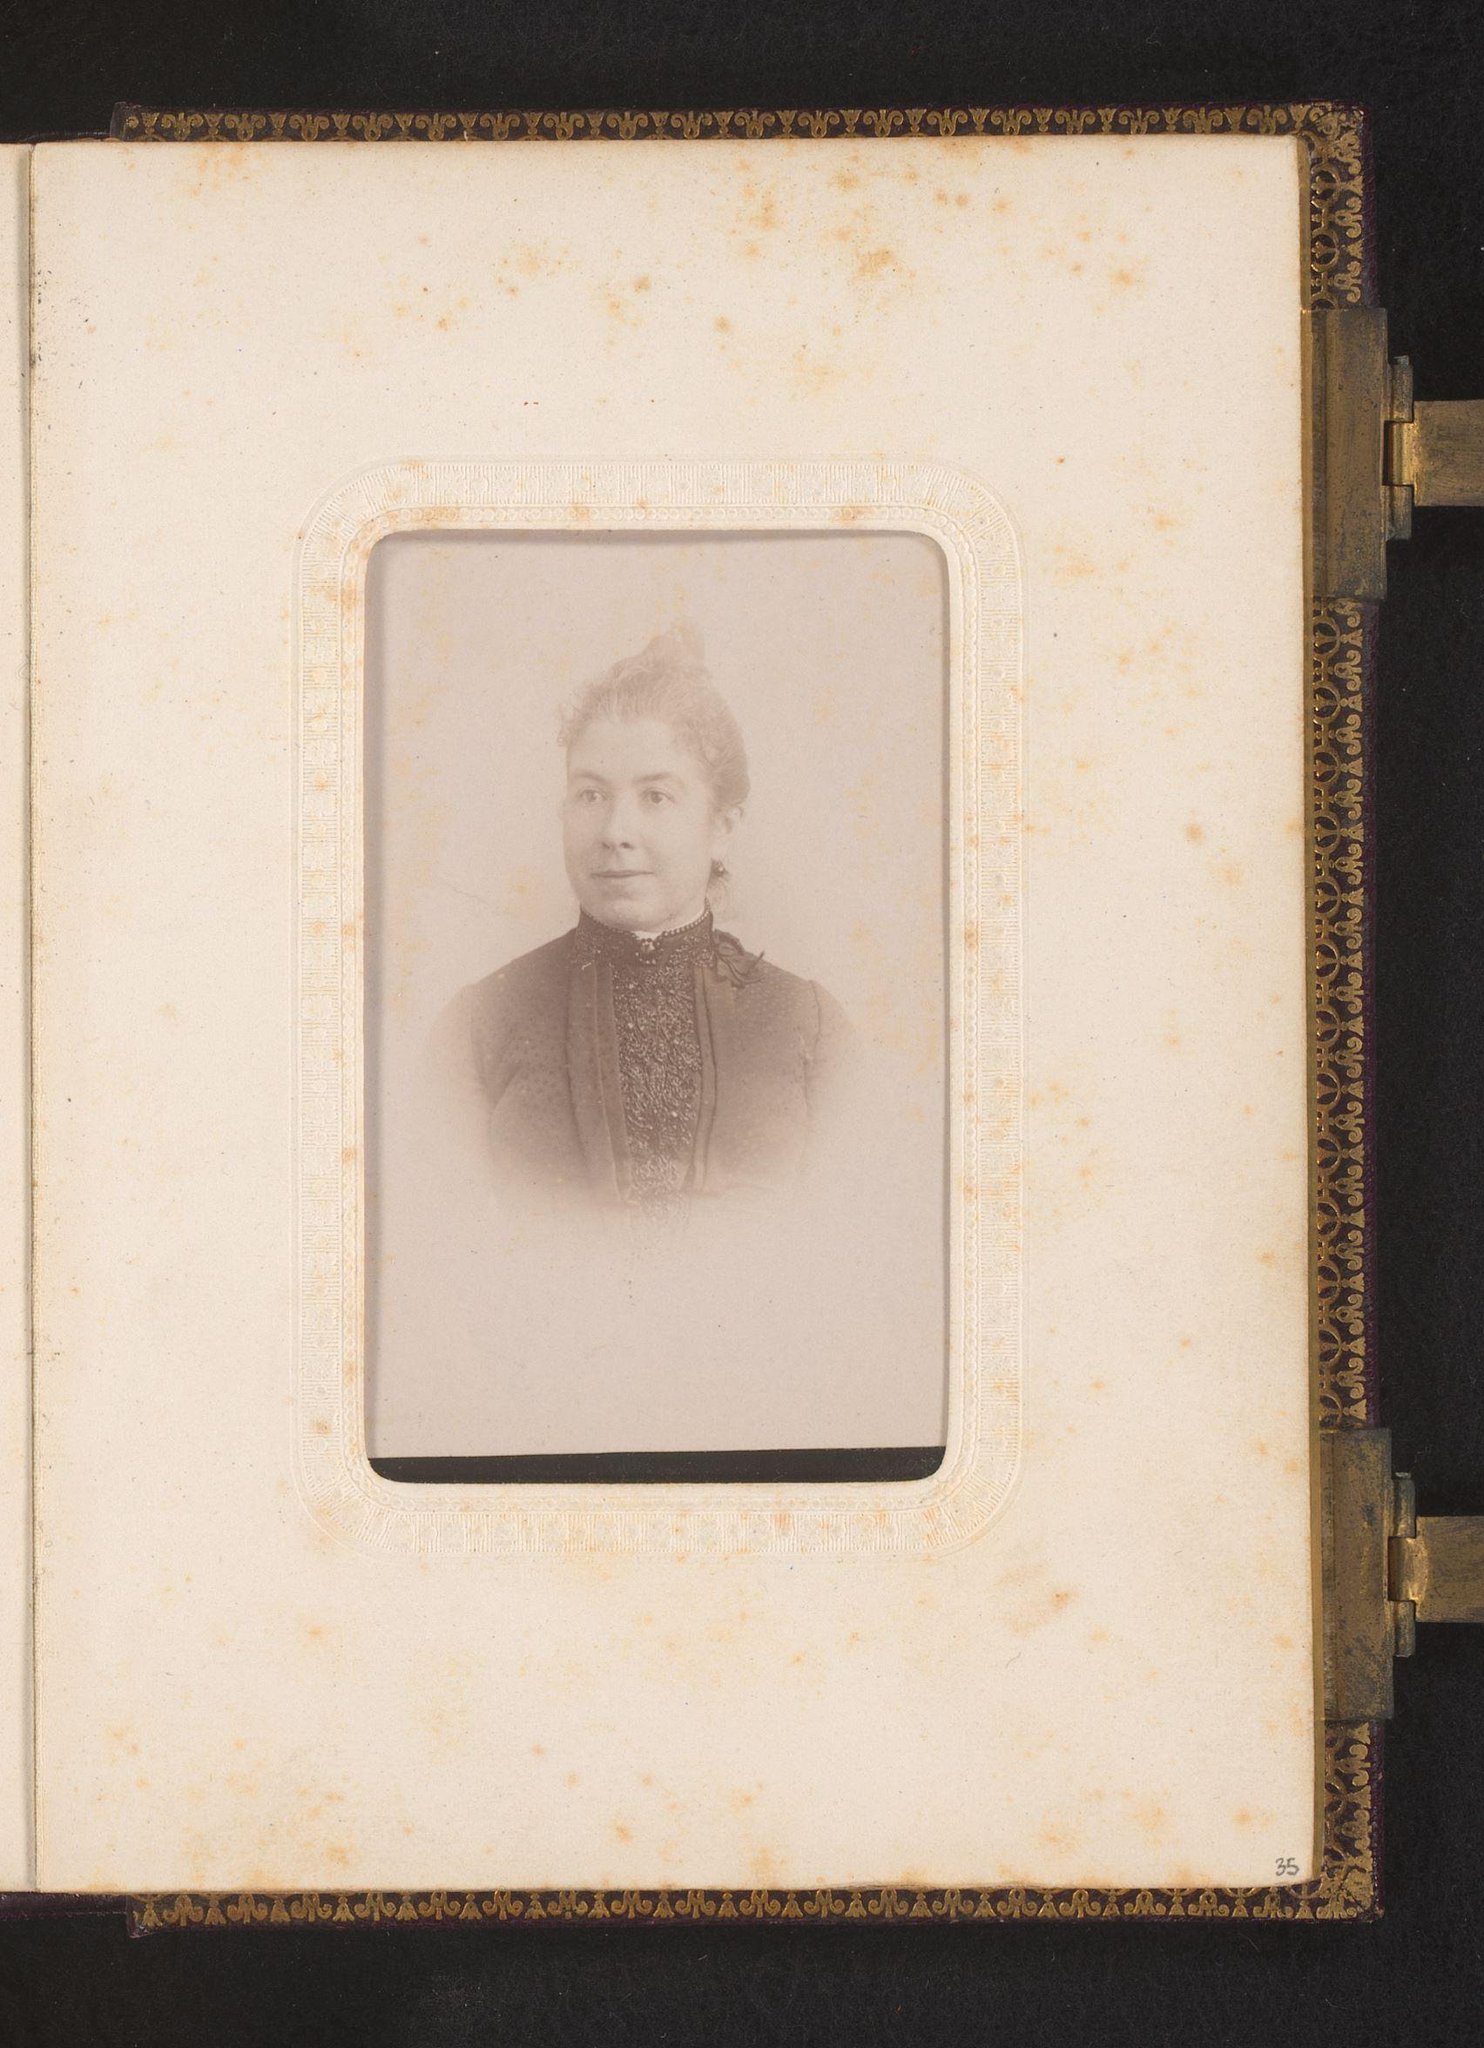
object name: carte de visite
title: Portret van een vrouw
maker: chamberlin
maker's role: fotograaf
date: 1860-1900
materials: cardboard, photographic support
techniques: albumen print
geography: paris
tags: historical persons - bb - woman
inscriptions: inscription: ‘Photographie/ artistique/ Chamberlin/ PARIS/ 4, rue Frochot 4./ près la place Pigalle./ Maison à pouyues-les-eaux (Nièvre)/ Specialités d'agrandissements et Reproductions.’